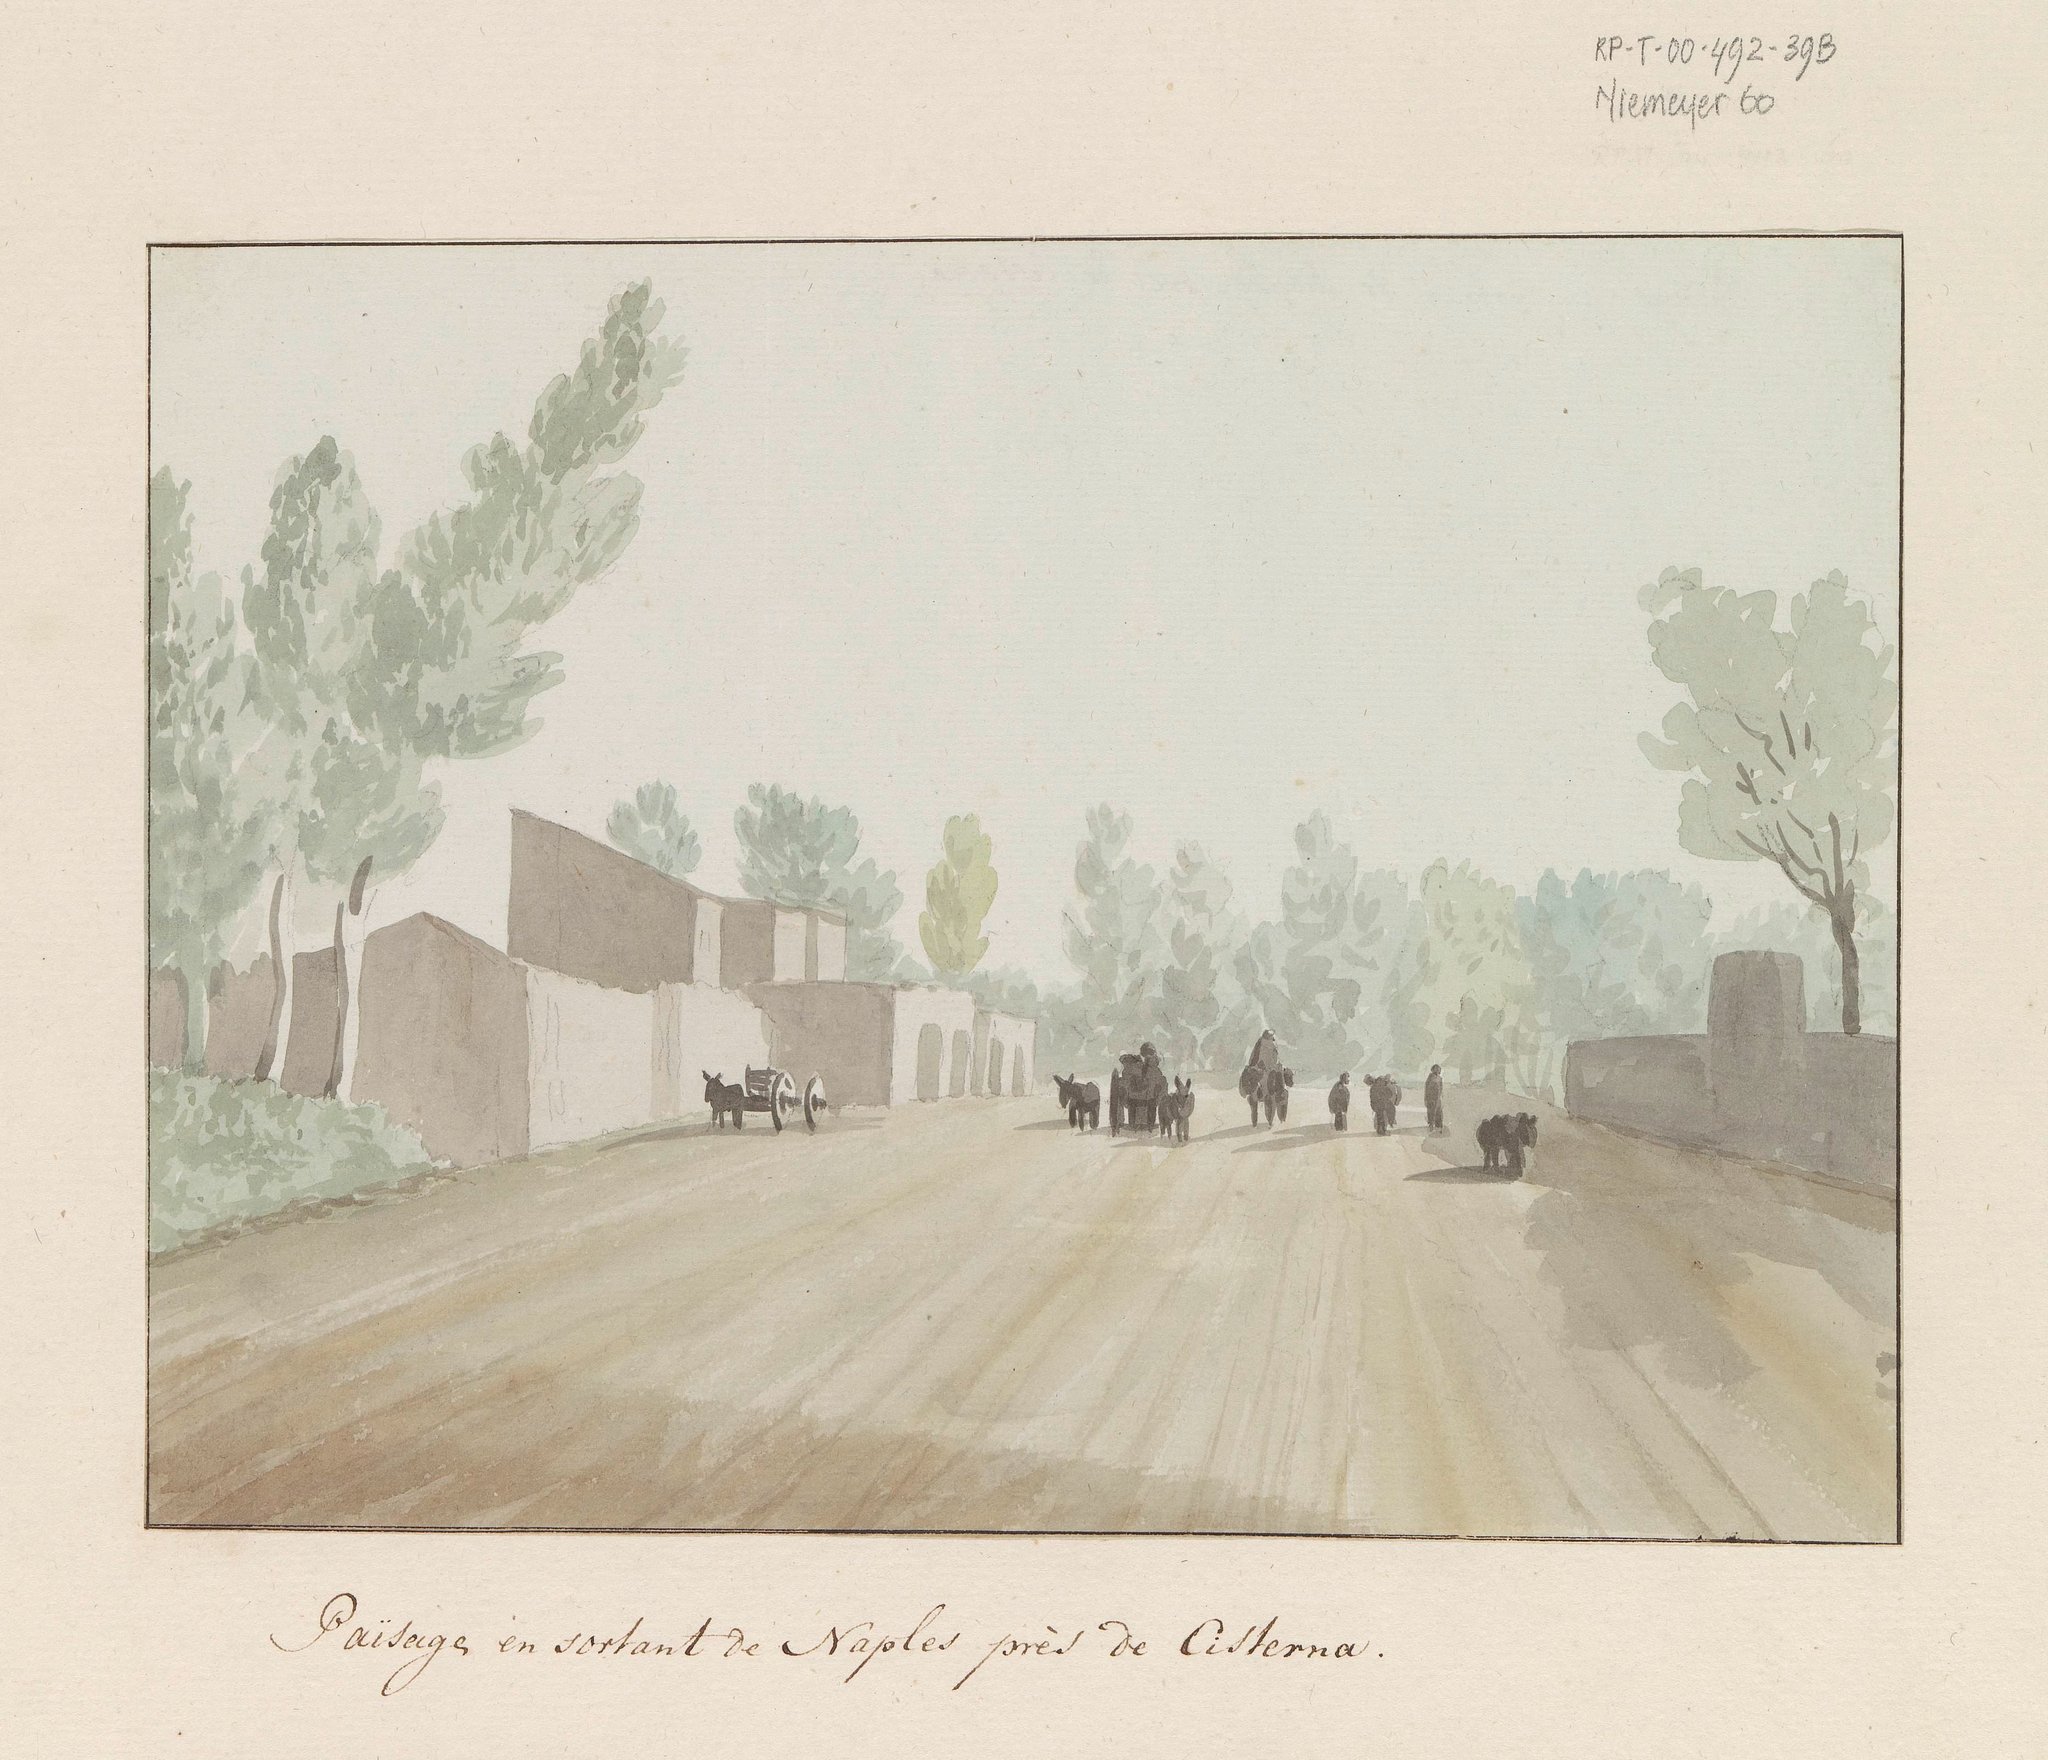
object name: watercolor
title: Straatbeeld bij verlaten van Napels ter hoogte van Cisterna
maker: louis ducros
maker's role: draughtsman, print maker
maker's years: 1748-1810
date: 1778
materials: chalk, paper, watercolor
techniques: brush, pen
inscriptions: number: ‘No 37 Païsage en sortant de Naples près de Cisterna’